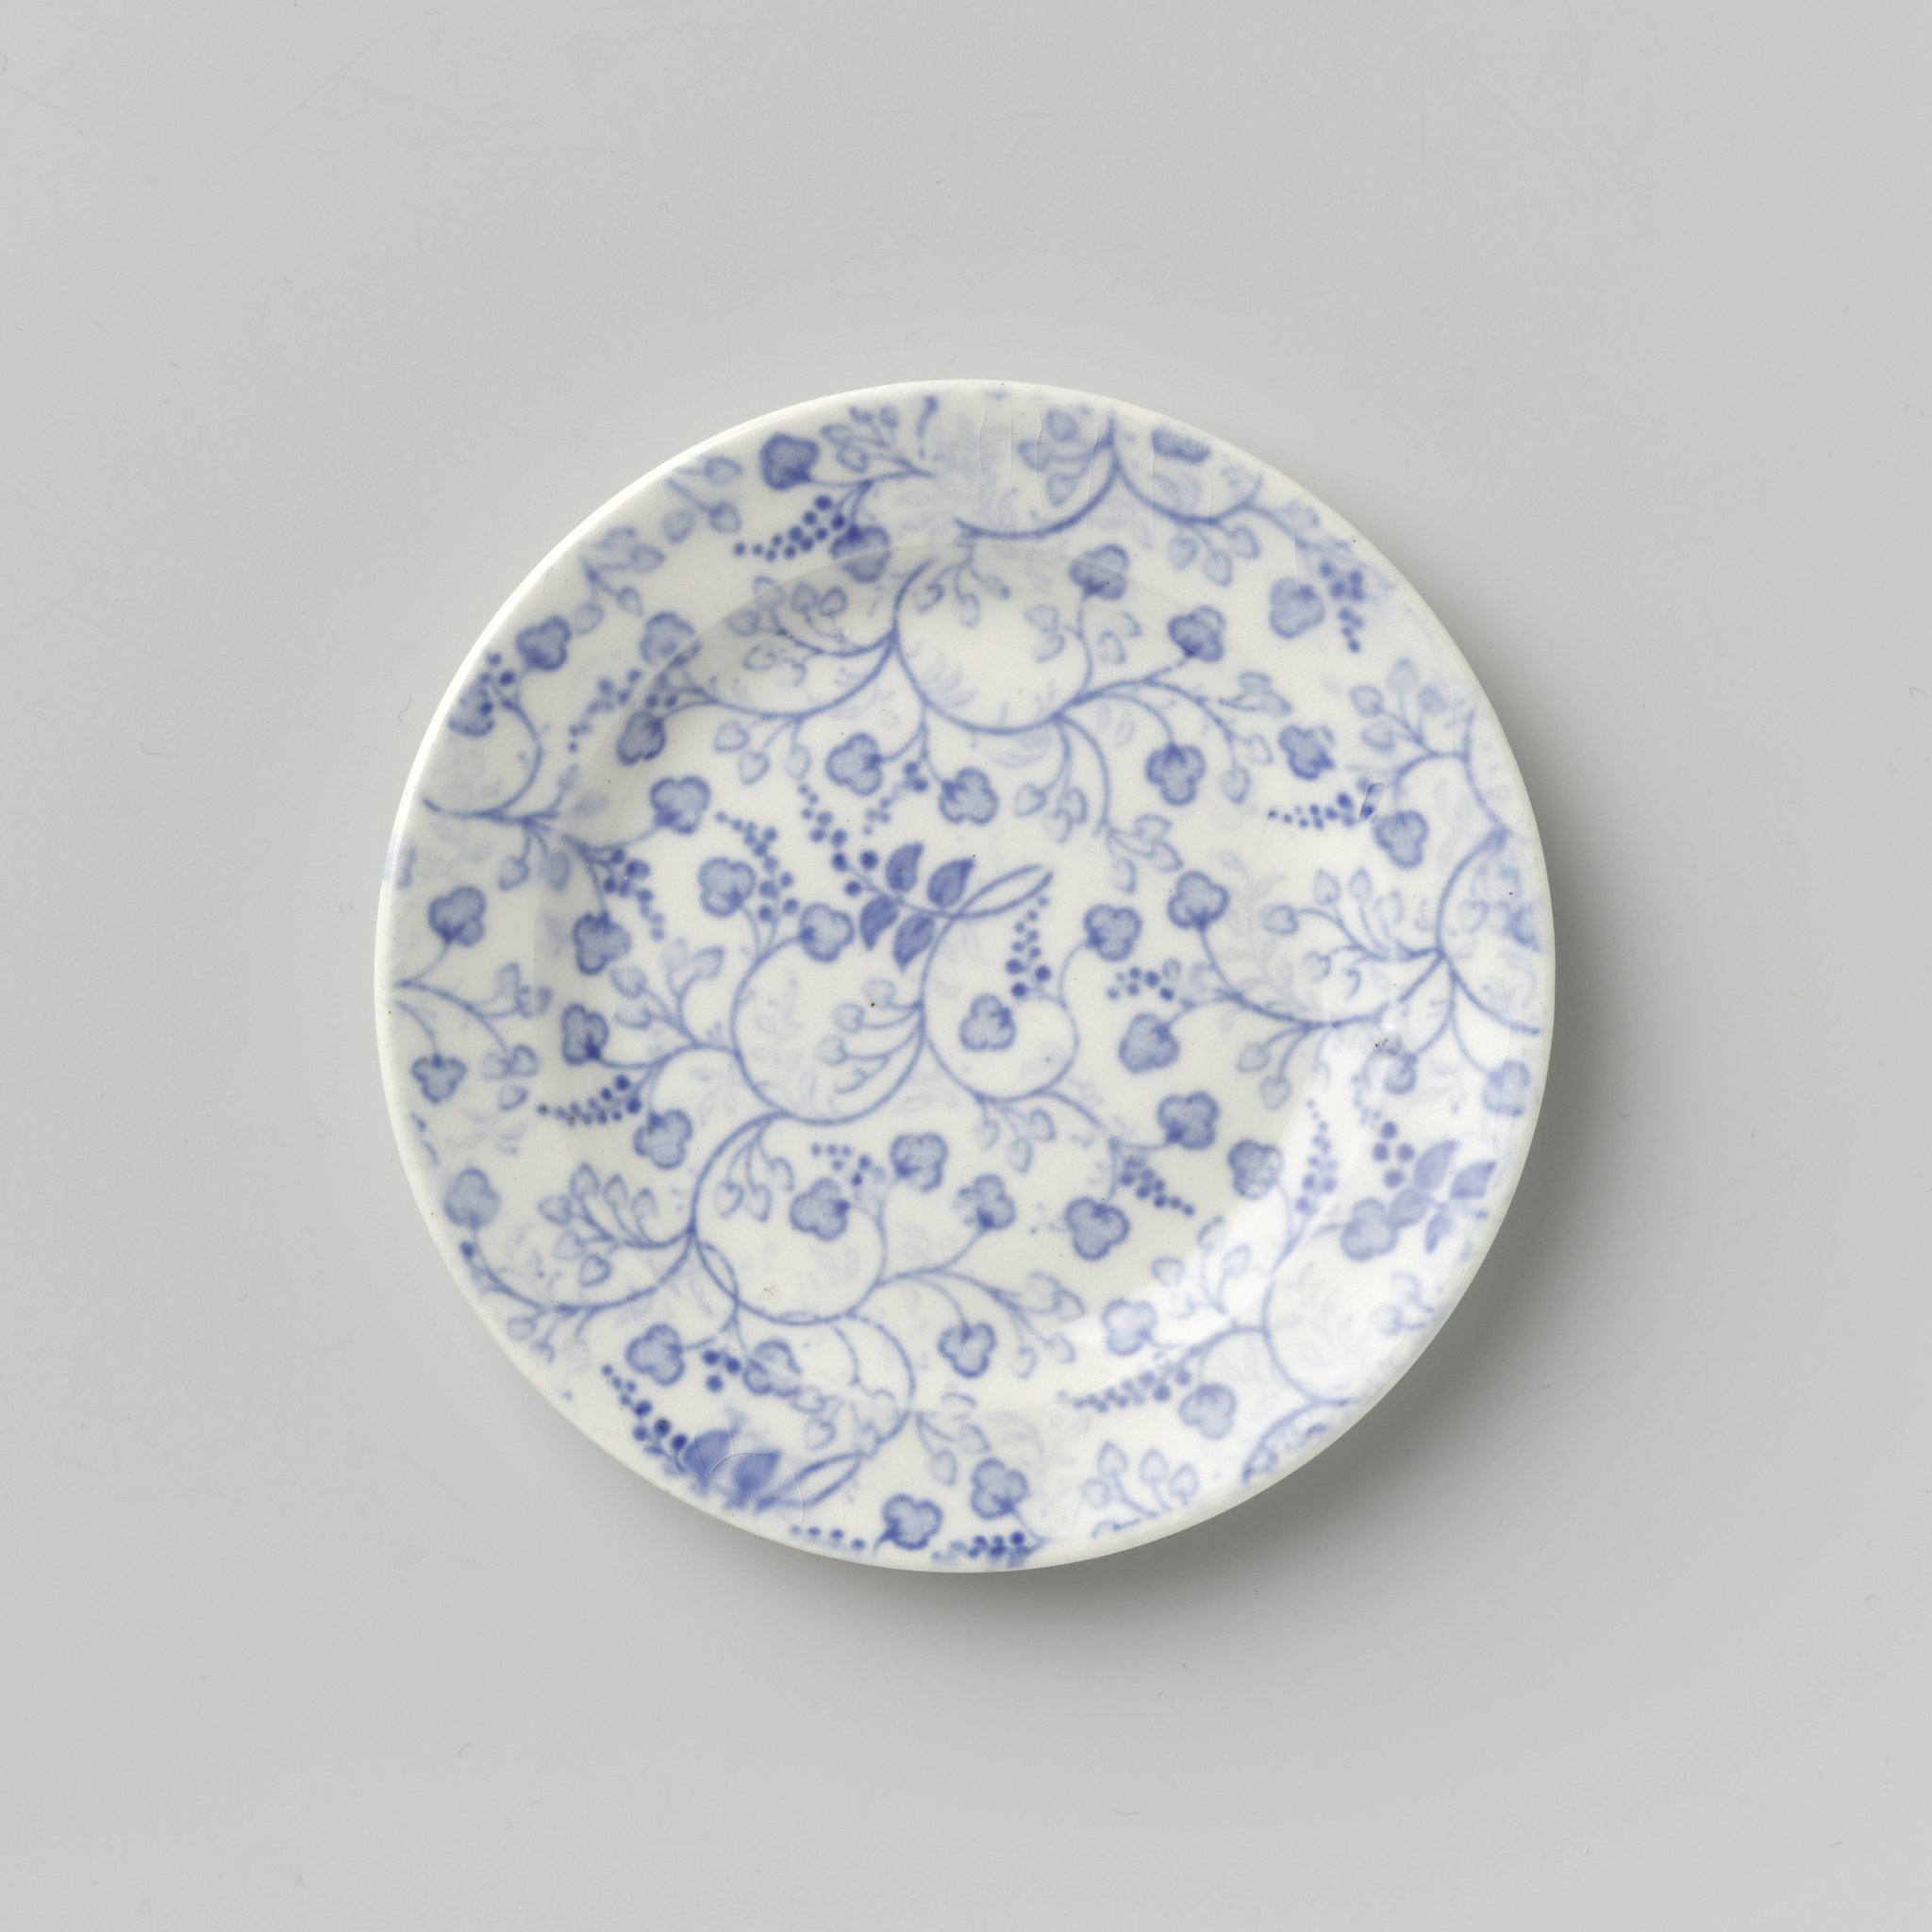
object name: plate dish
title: Bord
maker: petrus regout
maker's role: plateelbakker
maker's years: 1801-1879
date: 1867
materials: creamware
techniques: transfer decoration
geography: maastricht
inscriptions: mark: ‘2 67’, check stamp: ‘PR’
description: Bord van aardewerk, met blauw doorlopend bloemendecor, behorend tot een kinderservies.